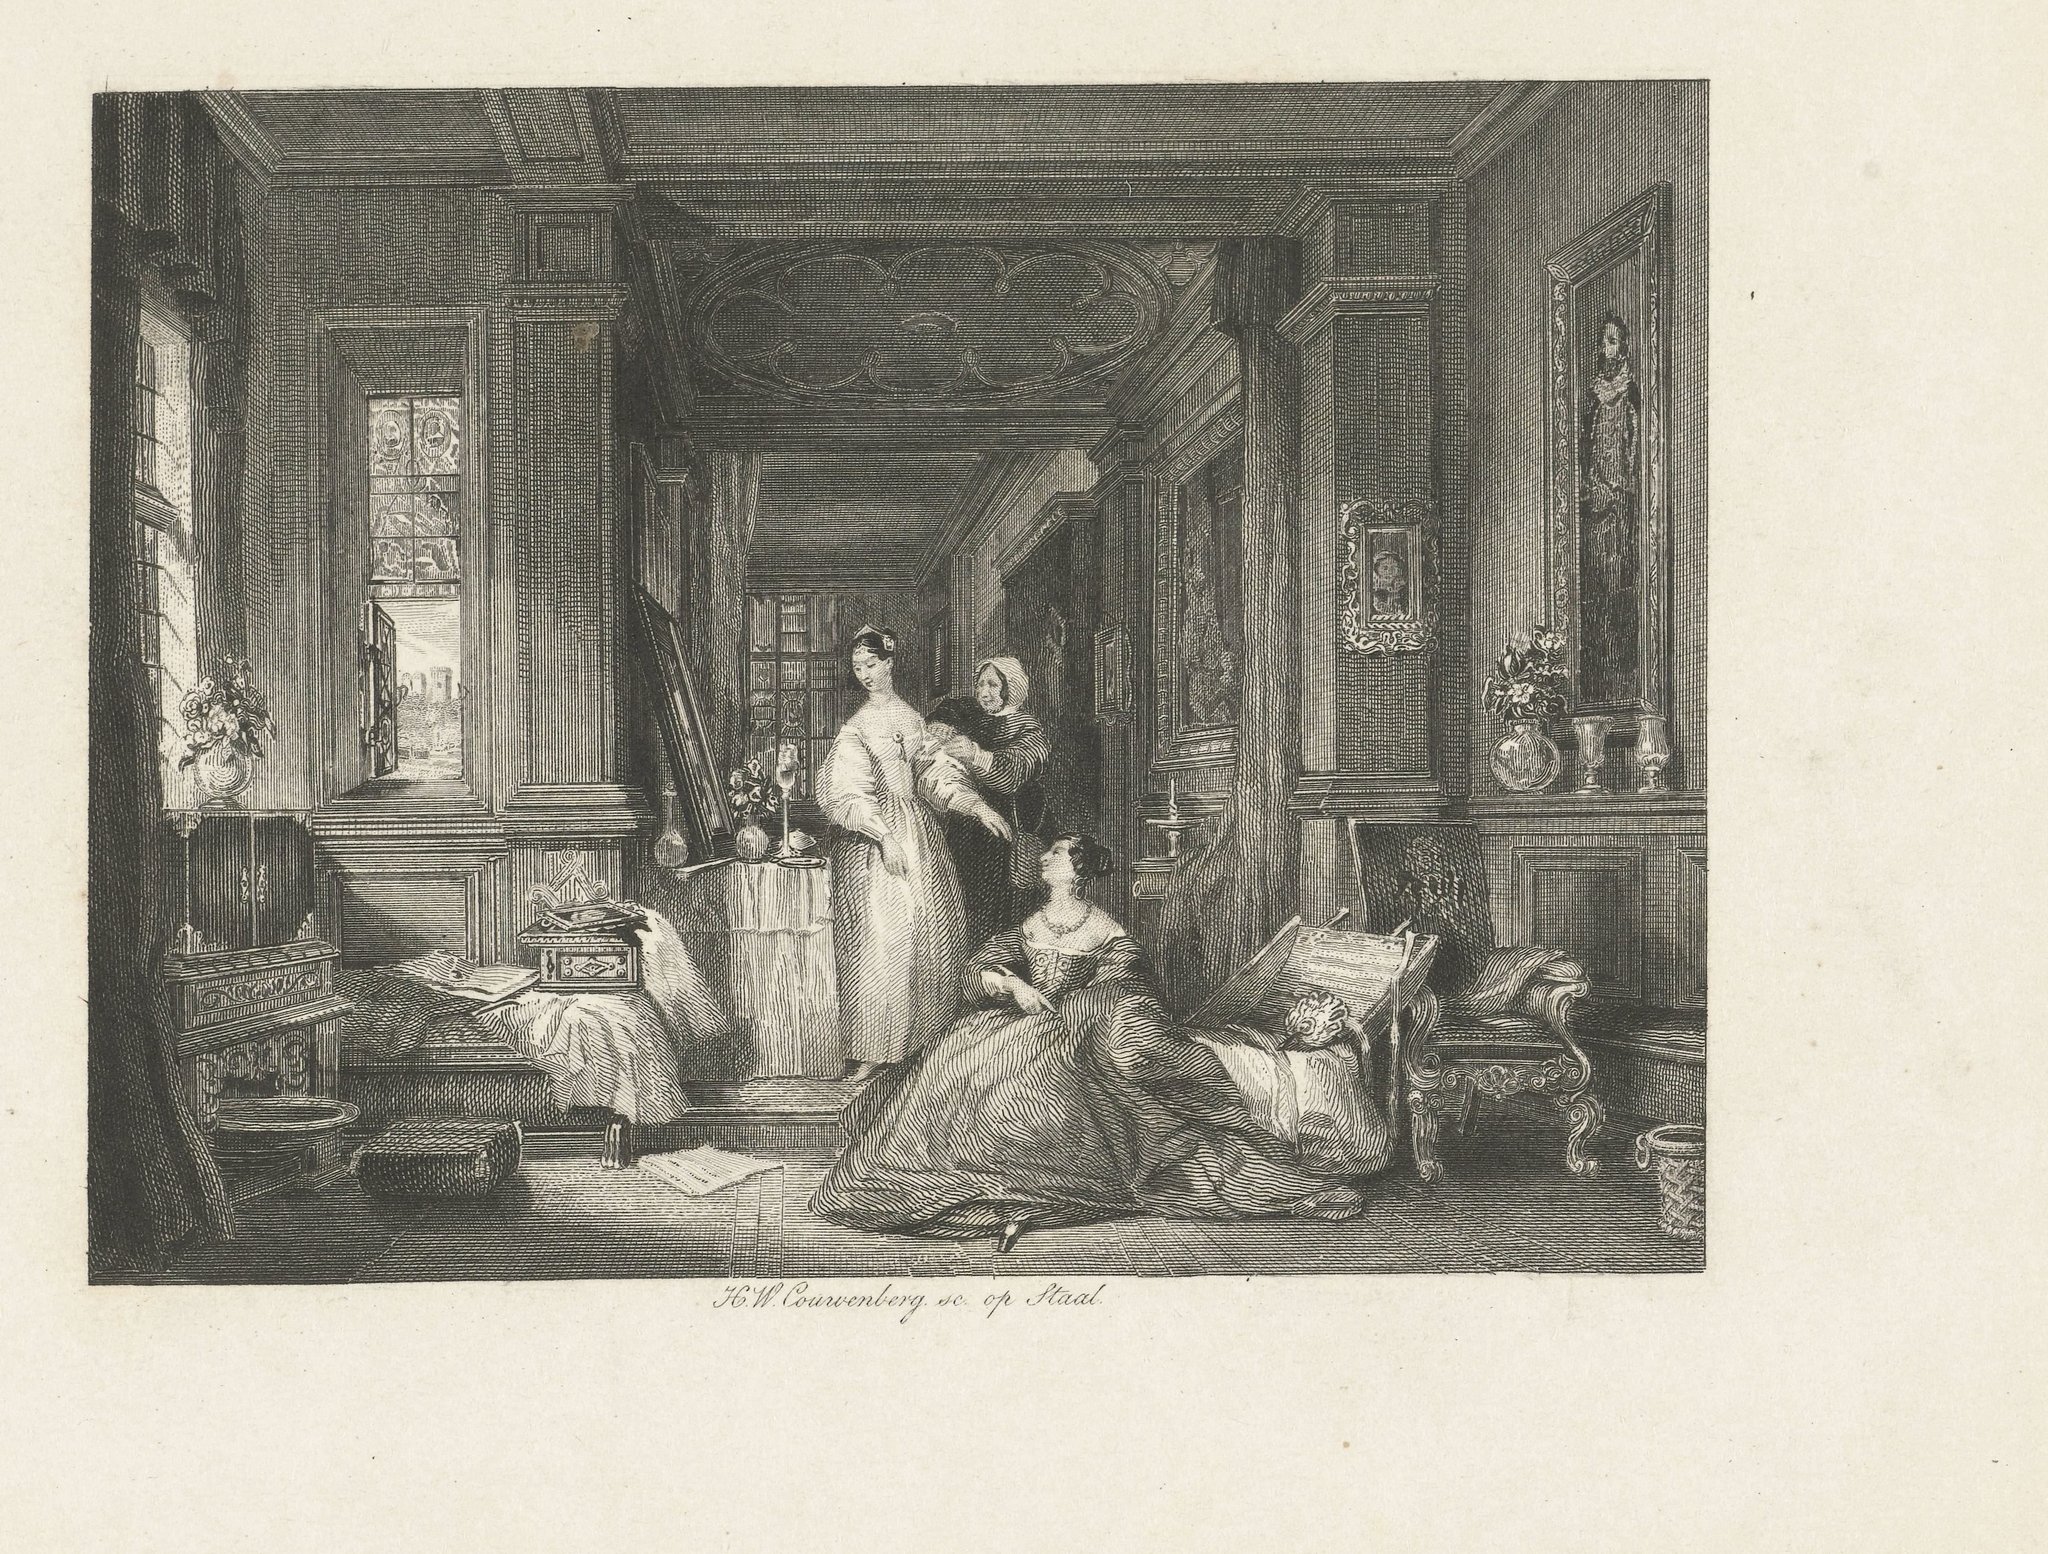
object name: print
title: Twee zusters in hun woonkamer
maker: henricus wilhelmus couwenberg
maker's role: draughtsman, print maker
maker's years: 1814-1845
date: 1838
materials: paper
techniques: engraving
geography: amsterdam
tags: mirror, dress, gown (+ women's clothes), dress, gown (+ fitting ~ home making of clothes)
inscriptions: collector's mark: Lugt 2228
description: Twee zusters in een woonvertrek. De ene zuster krijgt een nieuwe jurk aangemeten. Ze kijkt naar een spiegel die op een tafel staat. Een bediende zet naalden in de mouw. De andere zuster zit naast een kist met stof en toont haar zuster de mogelijkheden.